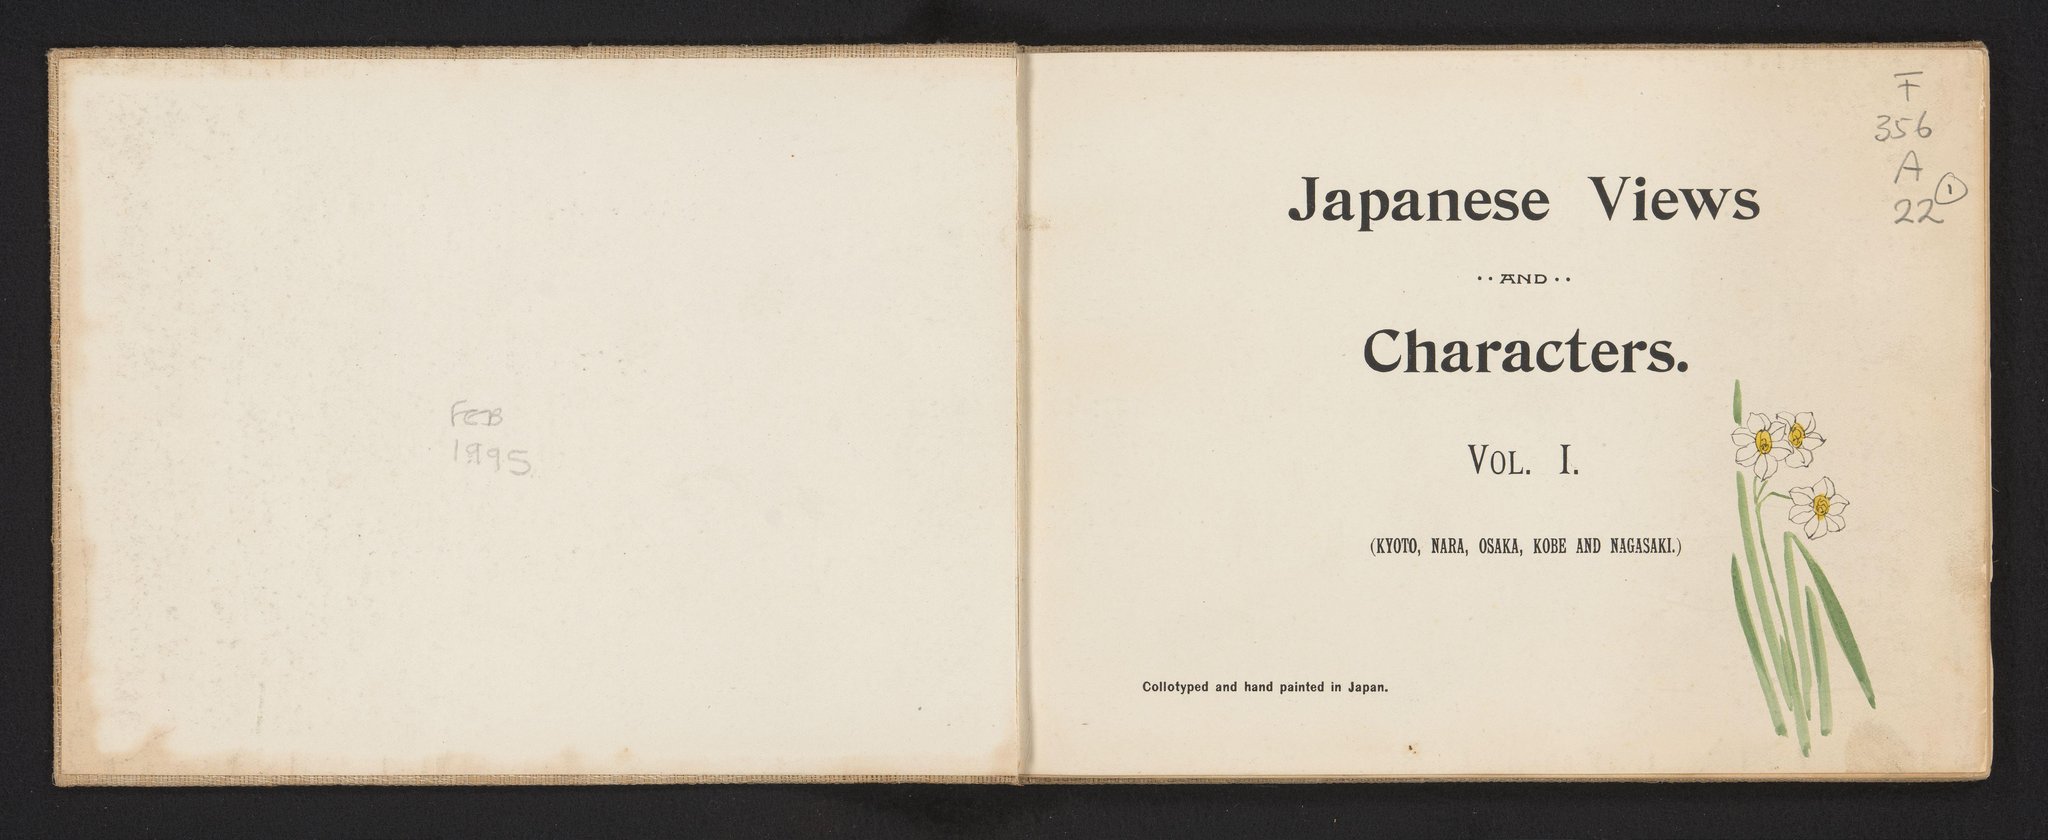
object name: book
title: Japanese views and characters Vol. I.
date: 1905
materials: linen, paint, paper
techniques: photograph, hand coloring